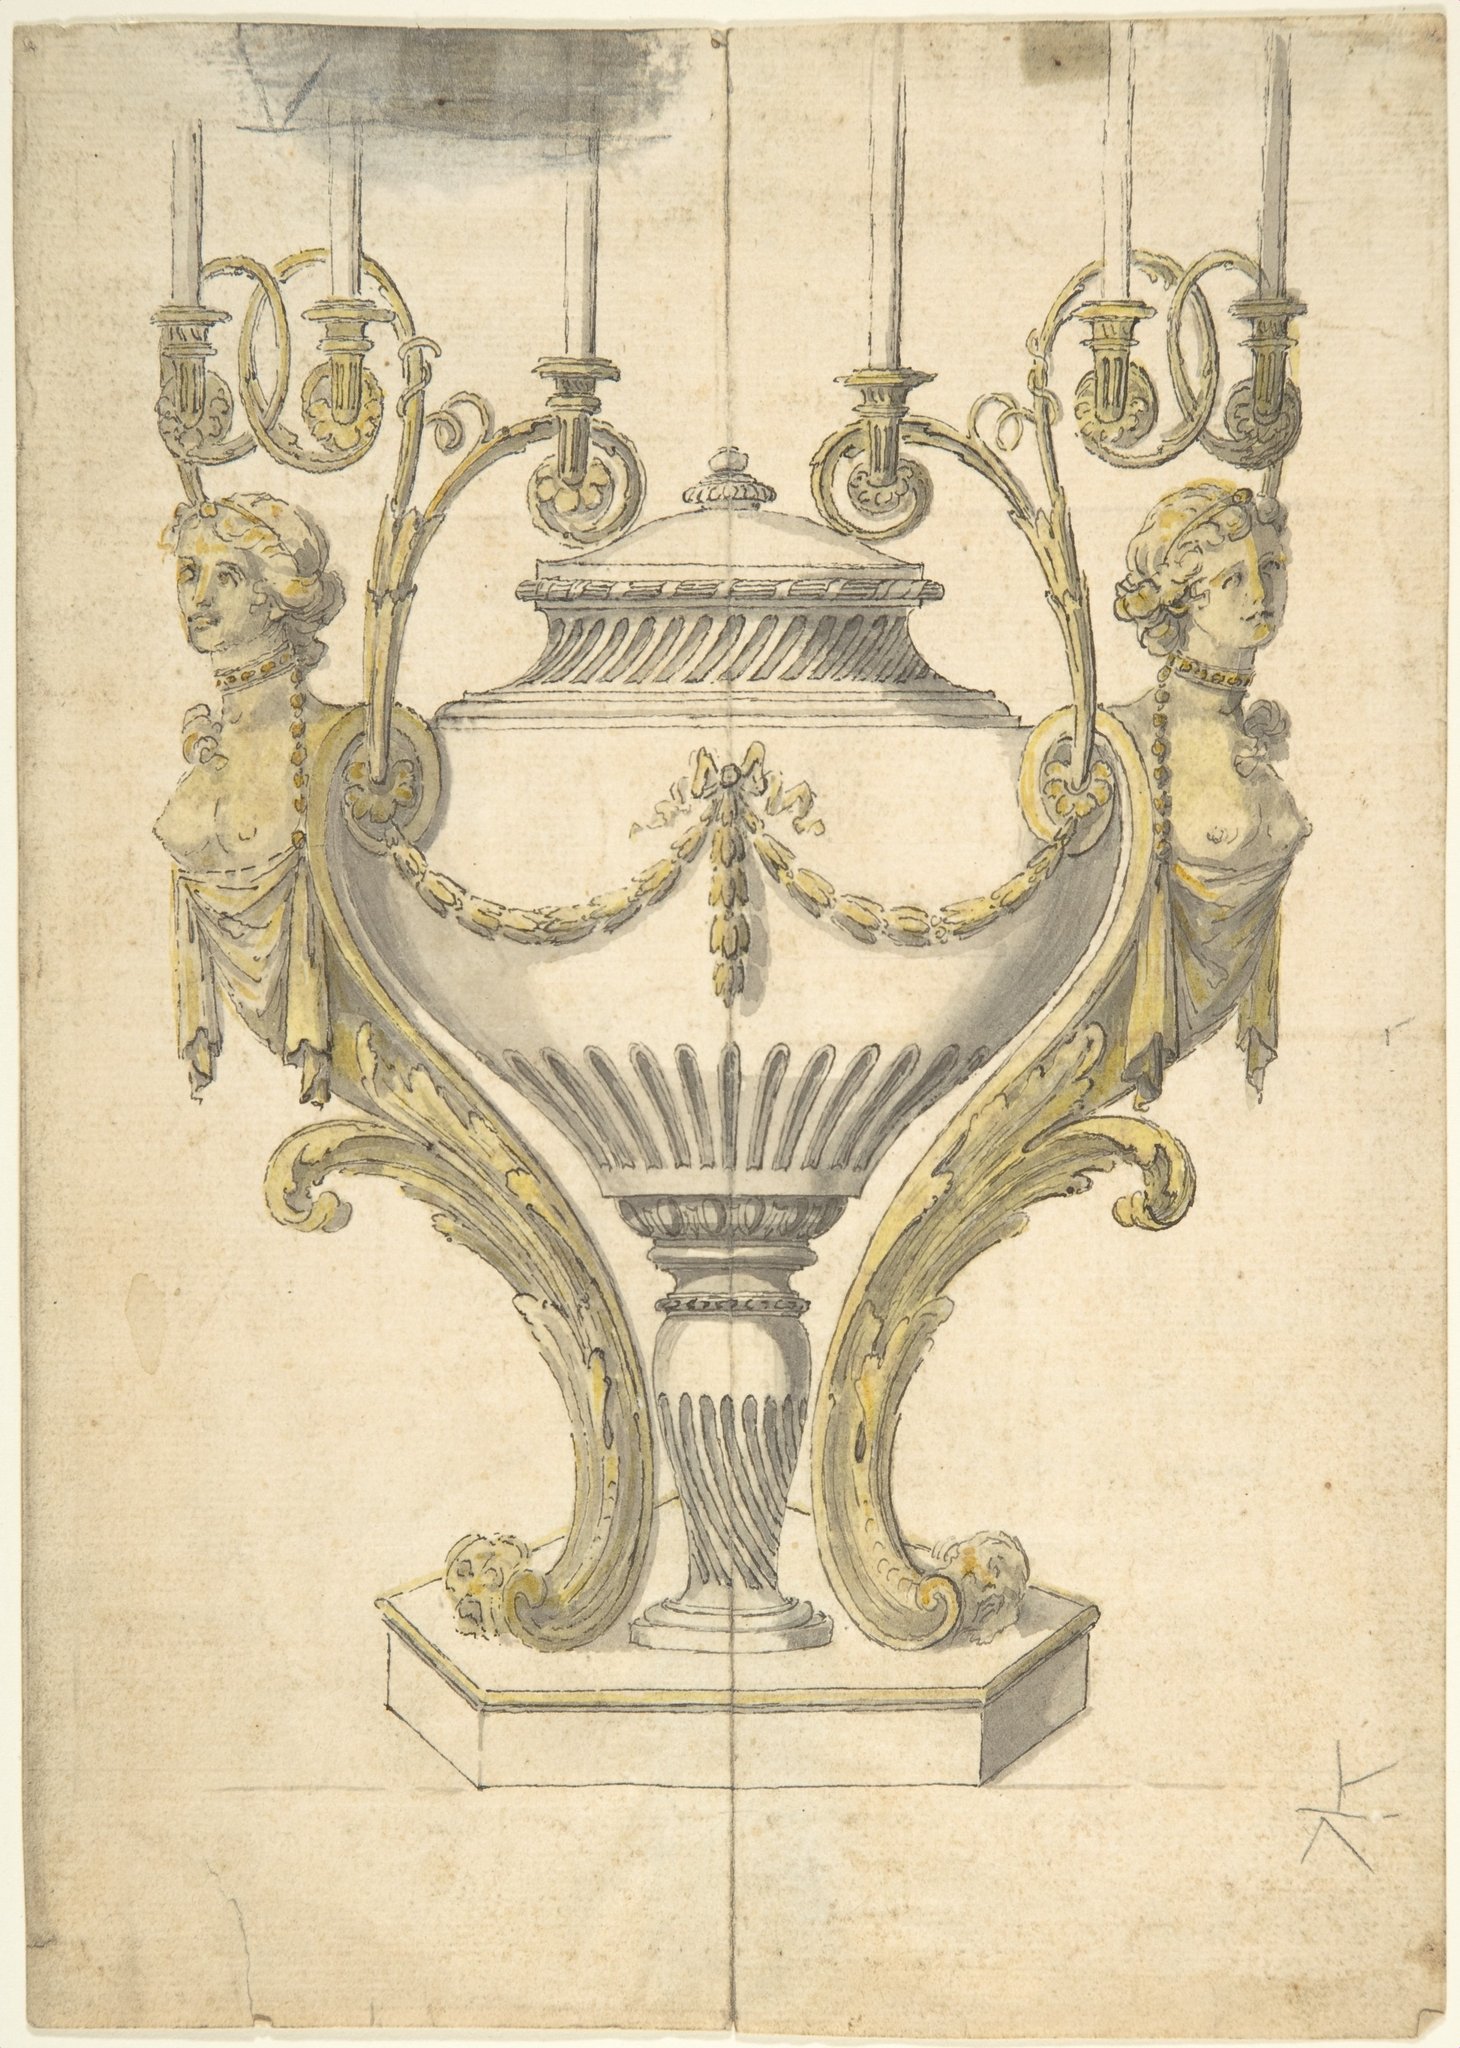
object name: drawing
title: Candelabrum in the form of an Urn Clasped by Carytides and Candle Branches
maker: henry holland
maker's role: artist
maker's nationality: british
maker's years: 1745-1806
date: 1760-1806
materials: ink, watercolor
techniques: brush, pen, wash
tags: caryatids,candelabra,urns